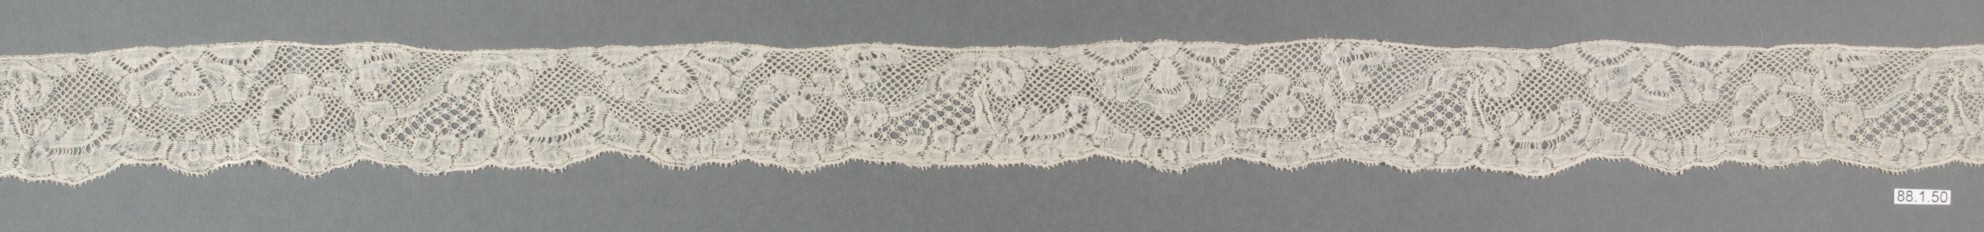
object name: strip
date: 1734-1766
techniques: lace